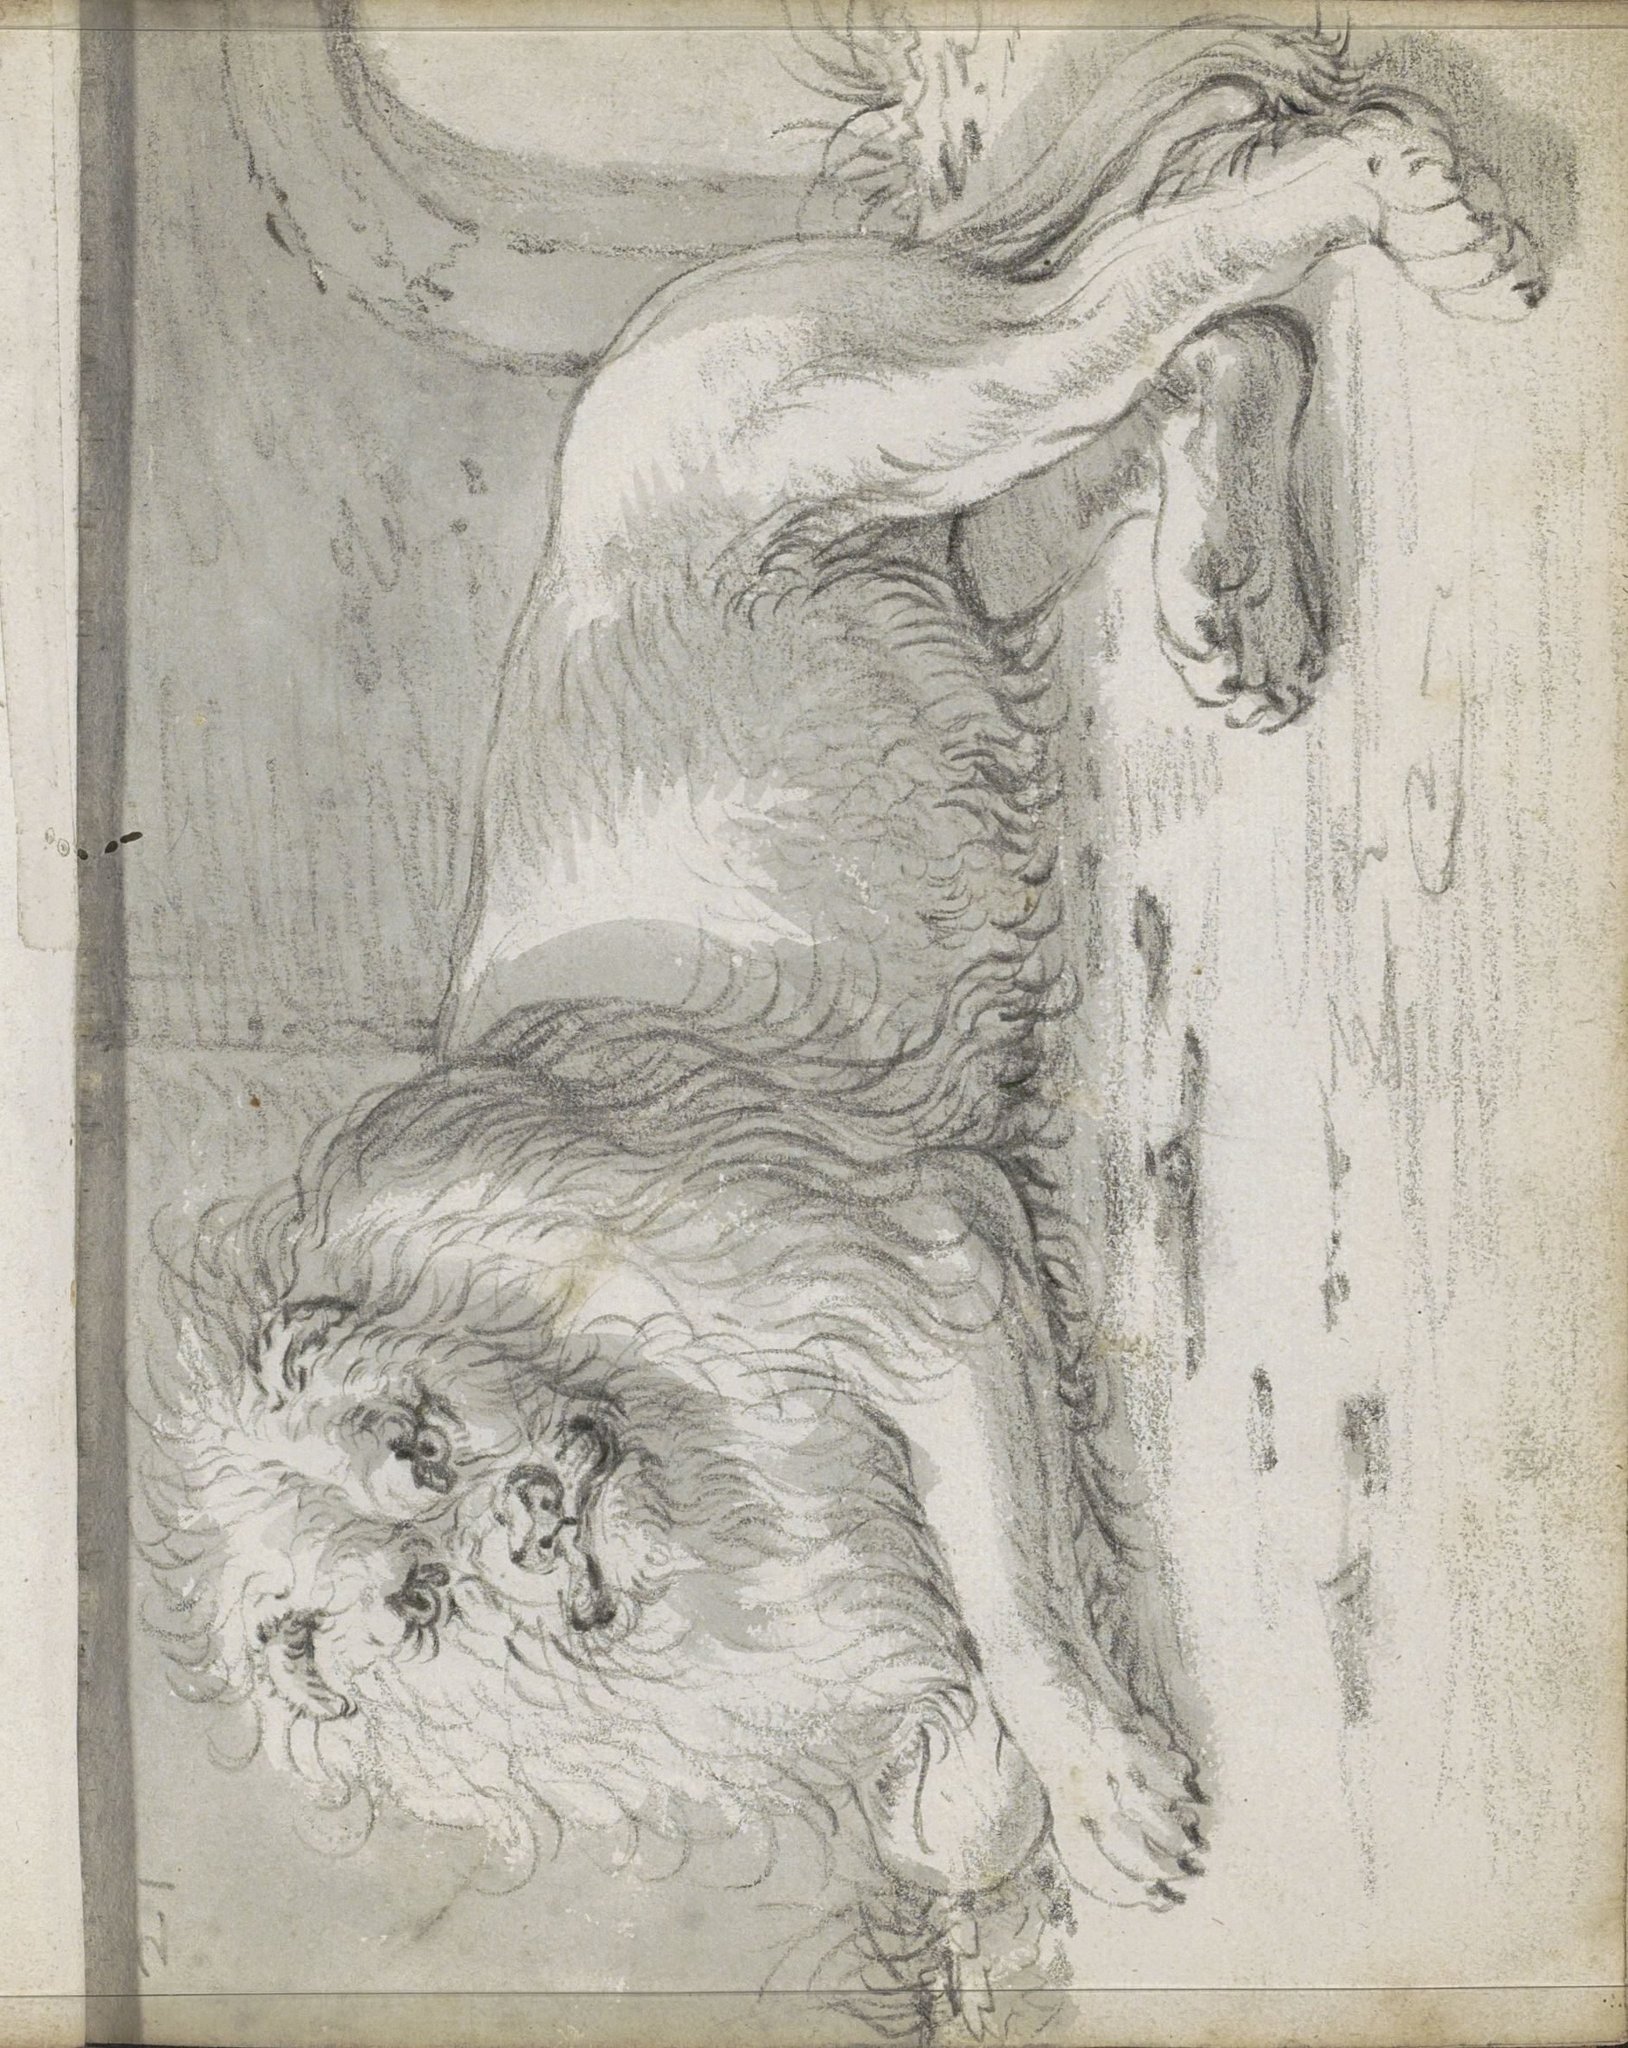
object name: sketchbook leaf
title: Liggende leeuw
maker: cornelis saftleven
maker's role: draughtsman, painter, print maker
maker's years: 1607-1681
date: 1666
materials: chalk, ink, paper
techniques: brush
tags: beasts of prey, predatory animals: lion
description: Blad 21 recto uit een schetsboek met 49 bladen.